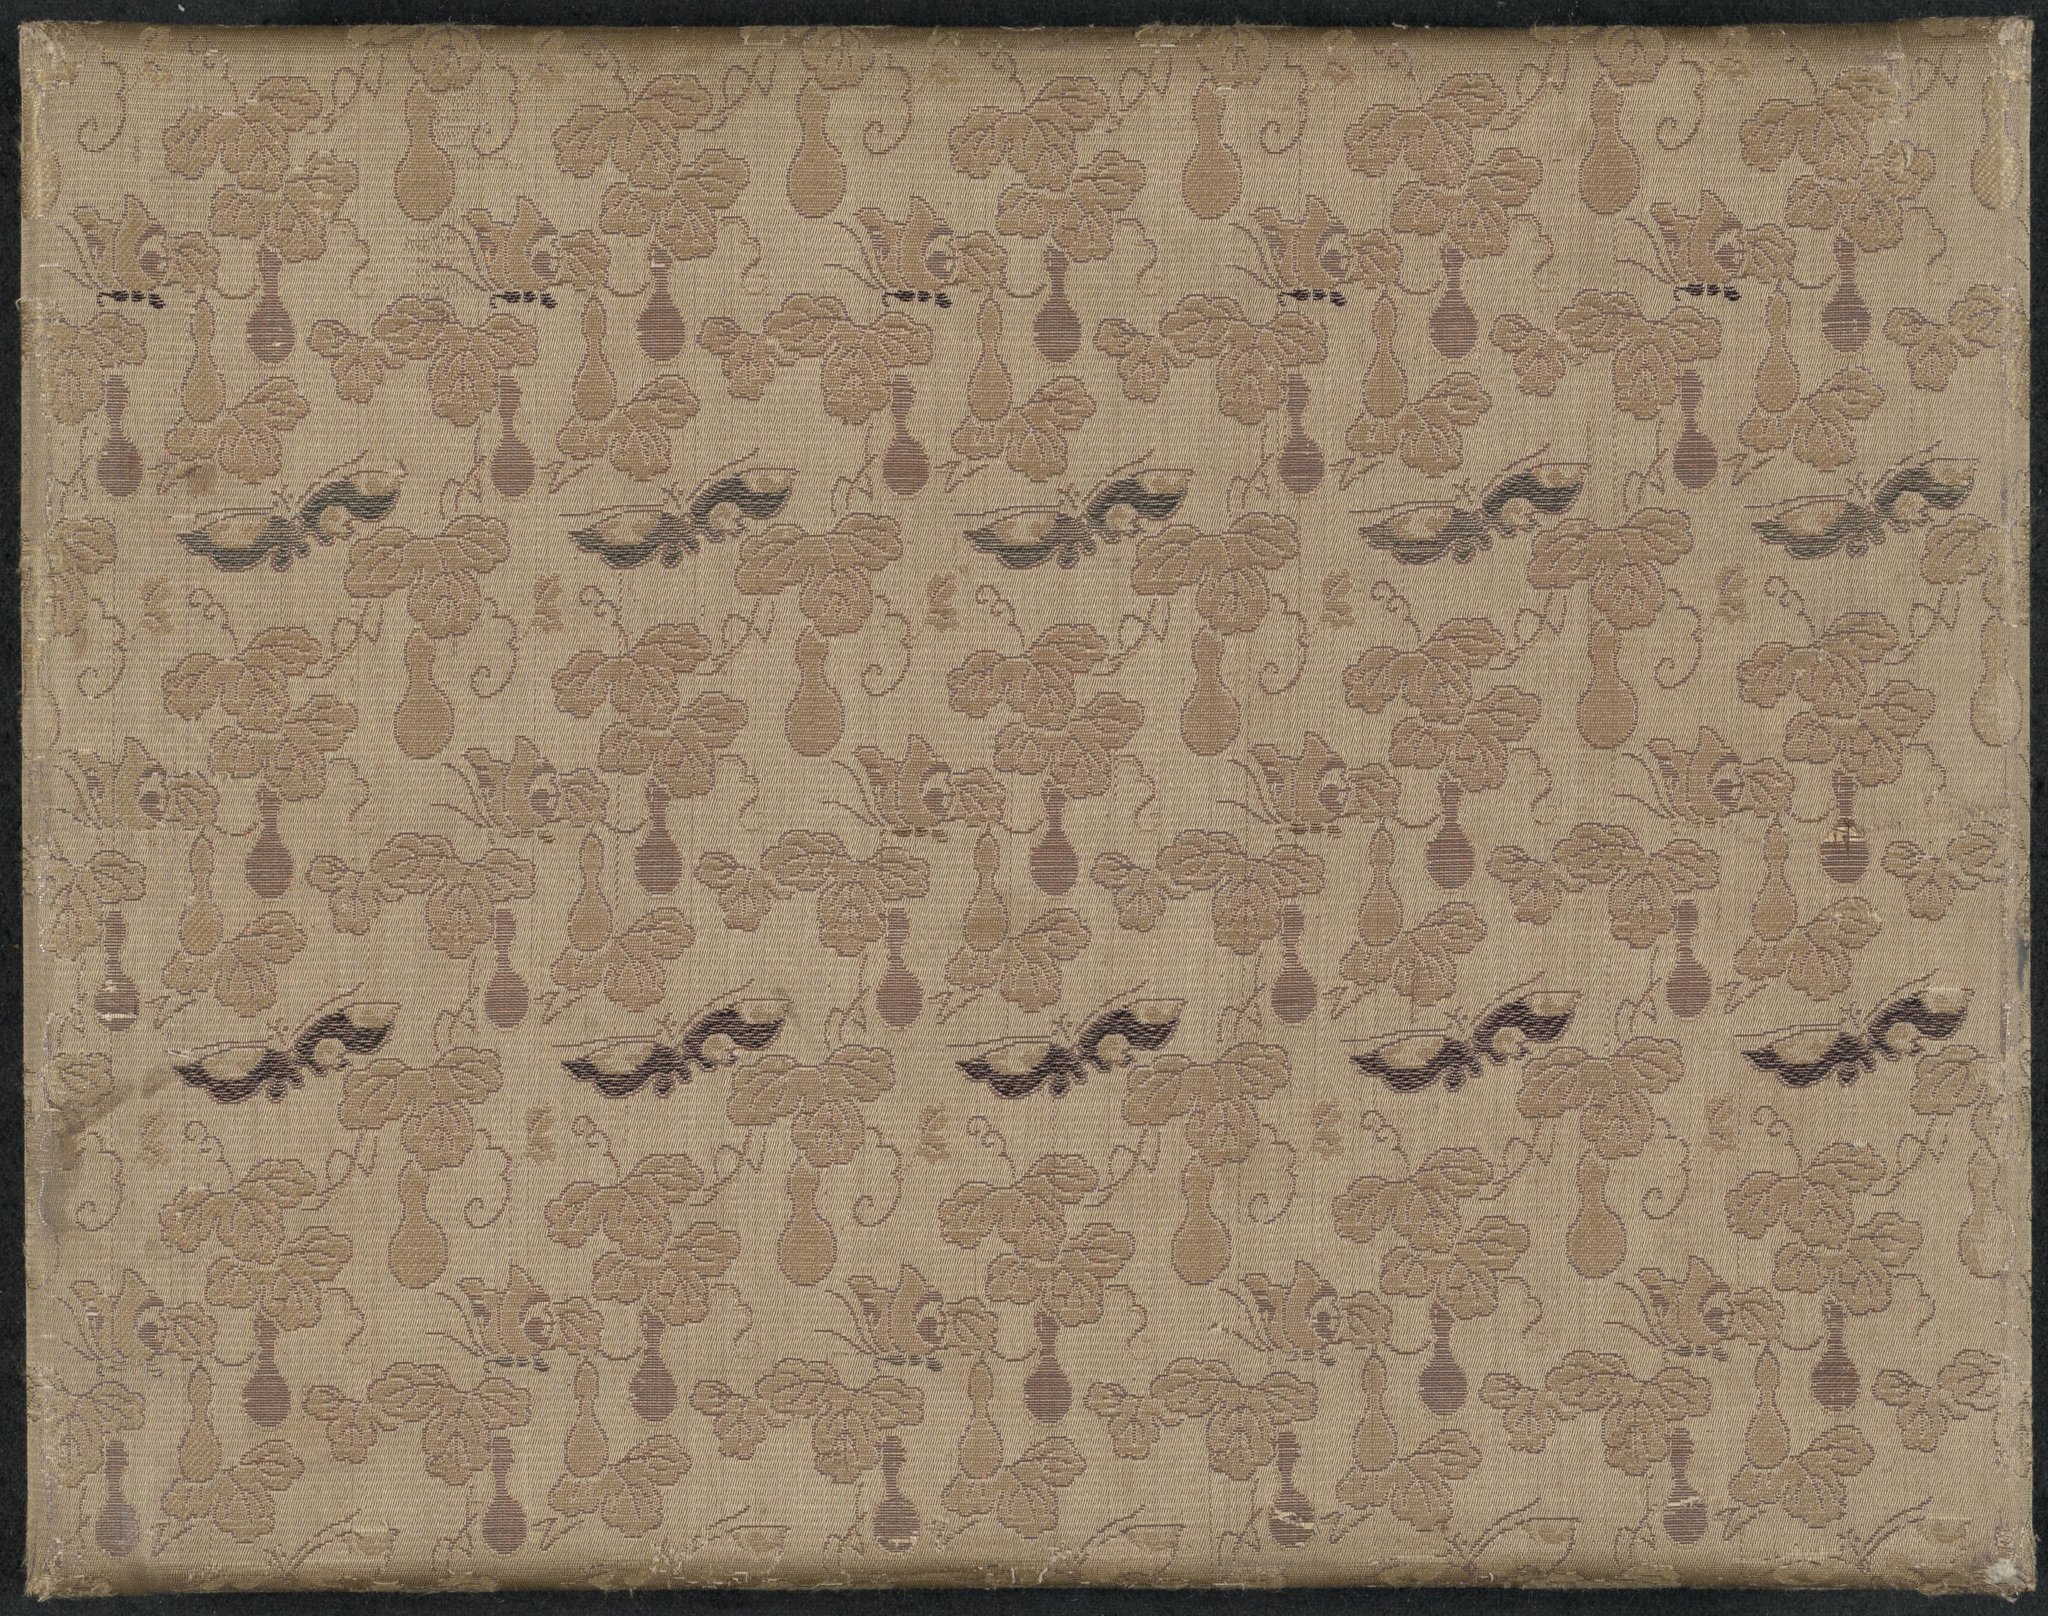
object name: photograph album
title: Leporelloalbum met 30 foto's van bezienswaardigheden in Japan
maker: Anonymous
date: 1870-1900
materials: cardboard, paper, photographic support, silk, textile, wood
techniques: albumen print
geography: japan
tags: temple, shrine ~ hinduism, buddhism, jainism, landscapes, village, travelling; tourism, japan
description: Leporelloalbum met voor- en achterzijde van beige zijde met bladmotief. Het album bevat 15 roomwitte kartonnen bladen die aan de randen zijn afgezet met een rand van mintgroen textiel. Daarop zijn 30 foto's geplakt van bezienswaardigheden in Japan, waaronder tempels, mausolea, bruggen, havens en landschappen.